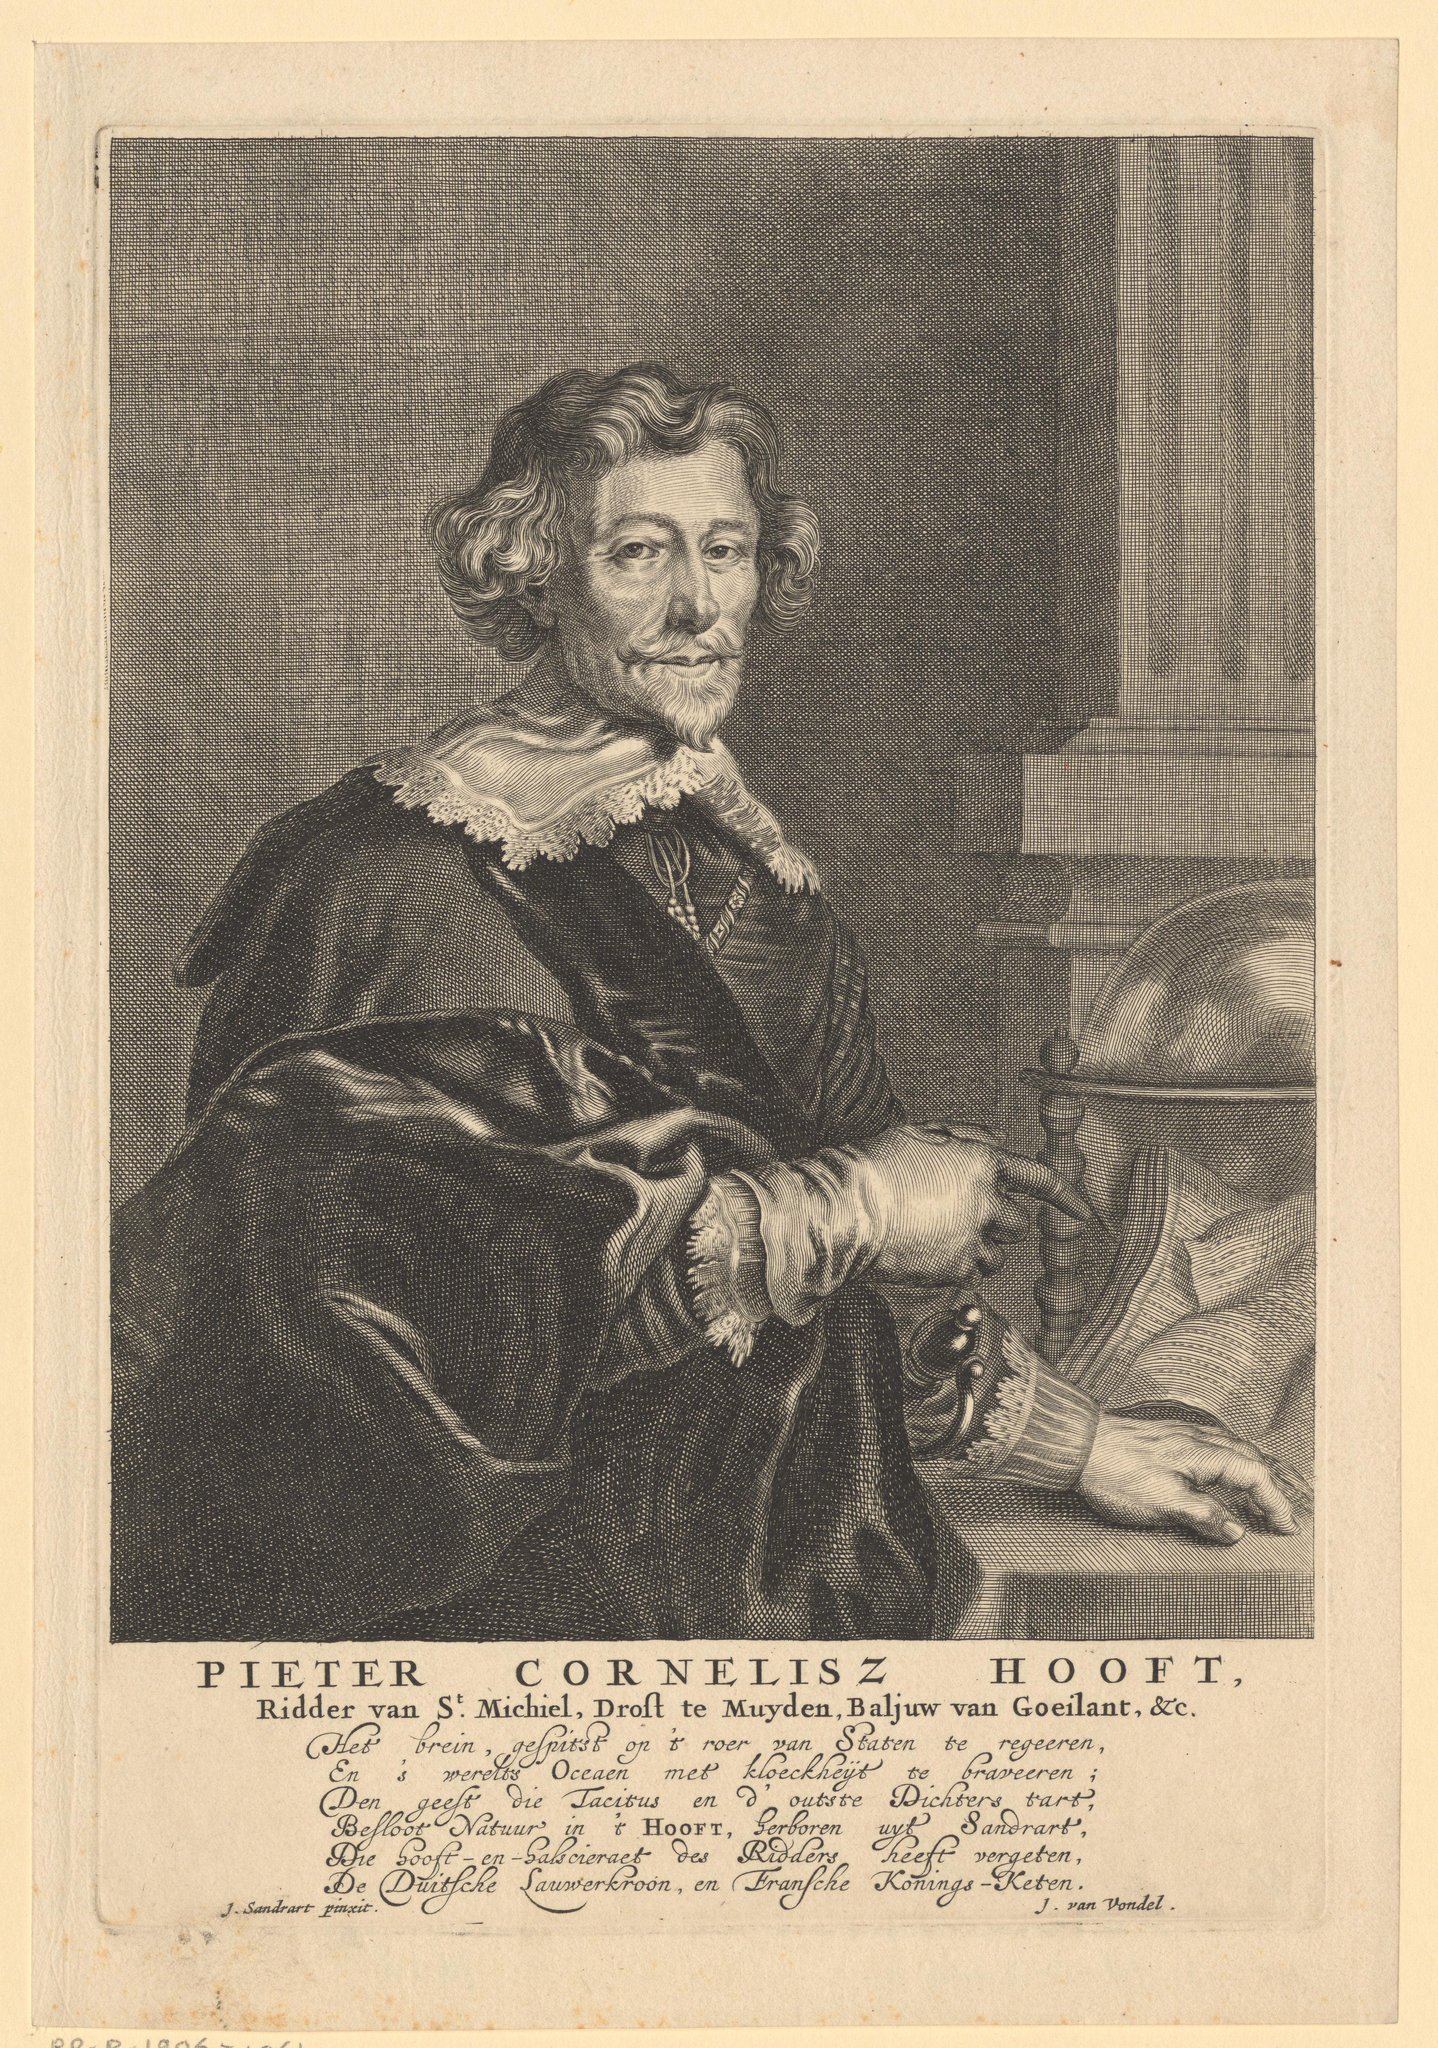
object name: print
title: Portret van Pieter Corneliszoon Hooft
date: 1655-1690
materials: paper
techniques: engraving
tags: amsterdam, the hague, pieter corneliszoon hooft, historical persons, book, writer, poet, author, globe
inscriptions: collector's mark: Lugt 2228